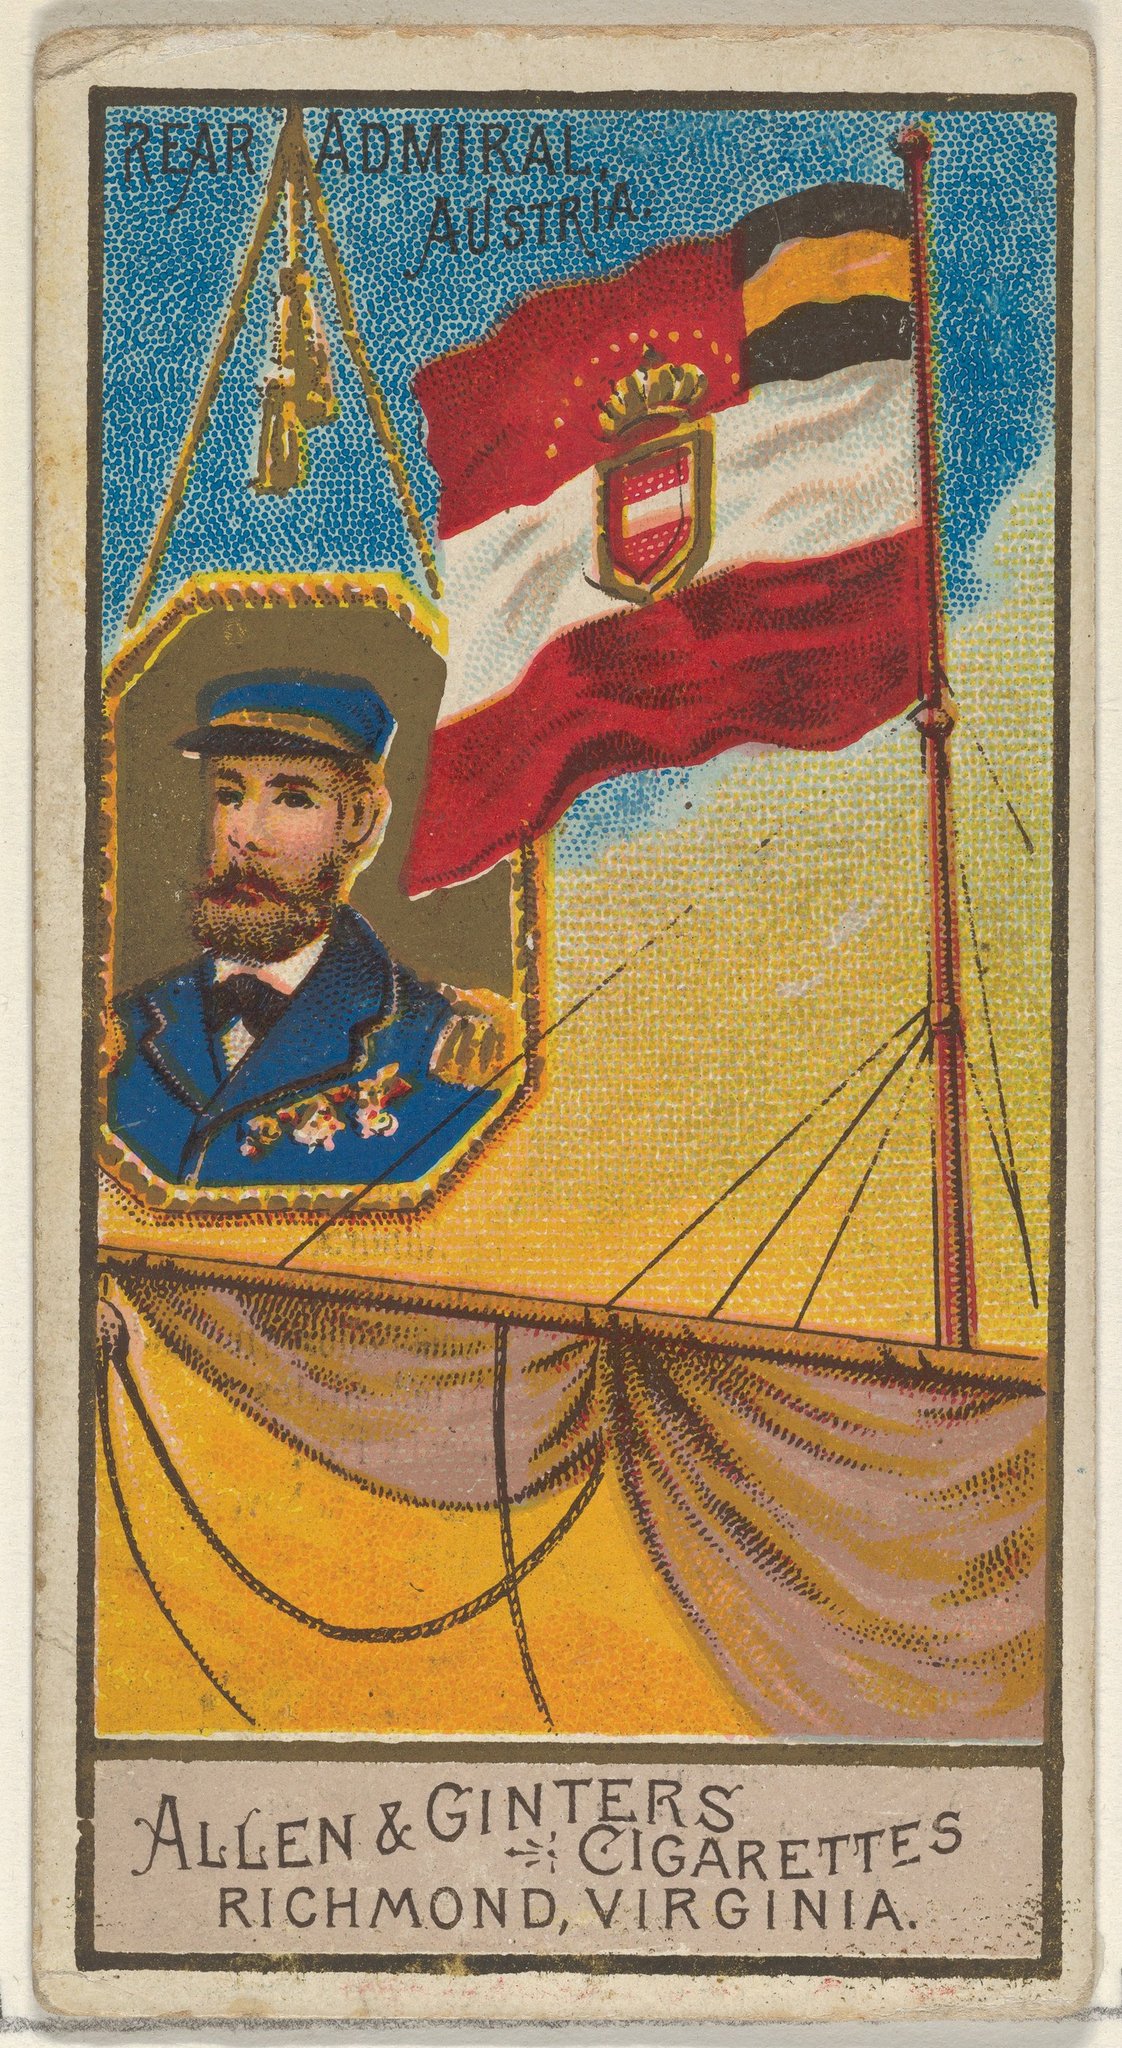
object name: print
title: Rear Admiral, Austria, from the Naval Flags series (N17) for Allen & Ginter Cigarettes Brands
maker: allen & ginter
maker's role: publisher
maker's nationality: american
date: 1888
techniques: color lithograph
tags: men,flags